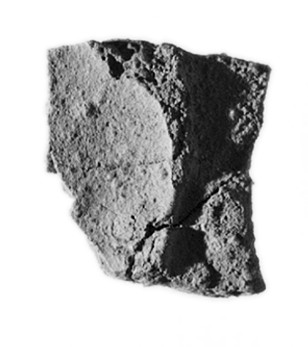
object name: sealing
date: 1981-1640 BCE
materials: mud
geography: egypt